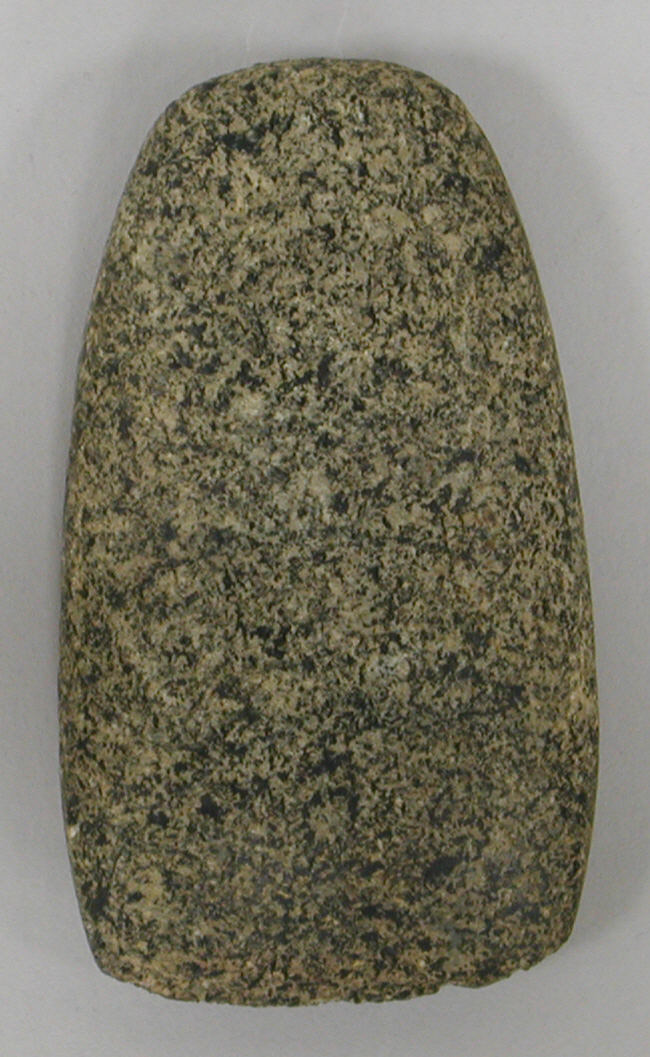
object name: celt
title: Stone Celt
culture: eastern woodlands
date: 1501-1600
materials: stone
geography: united states